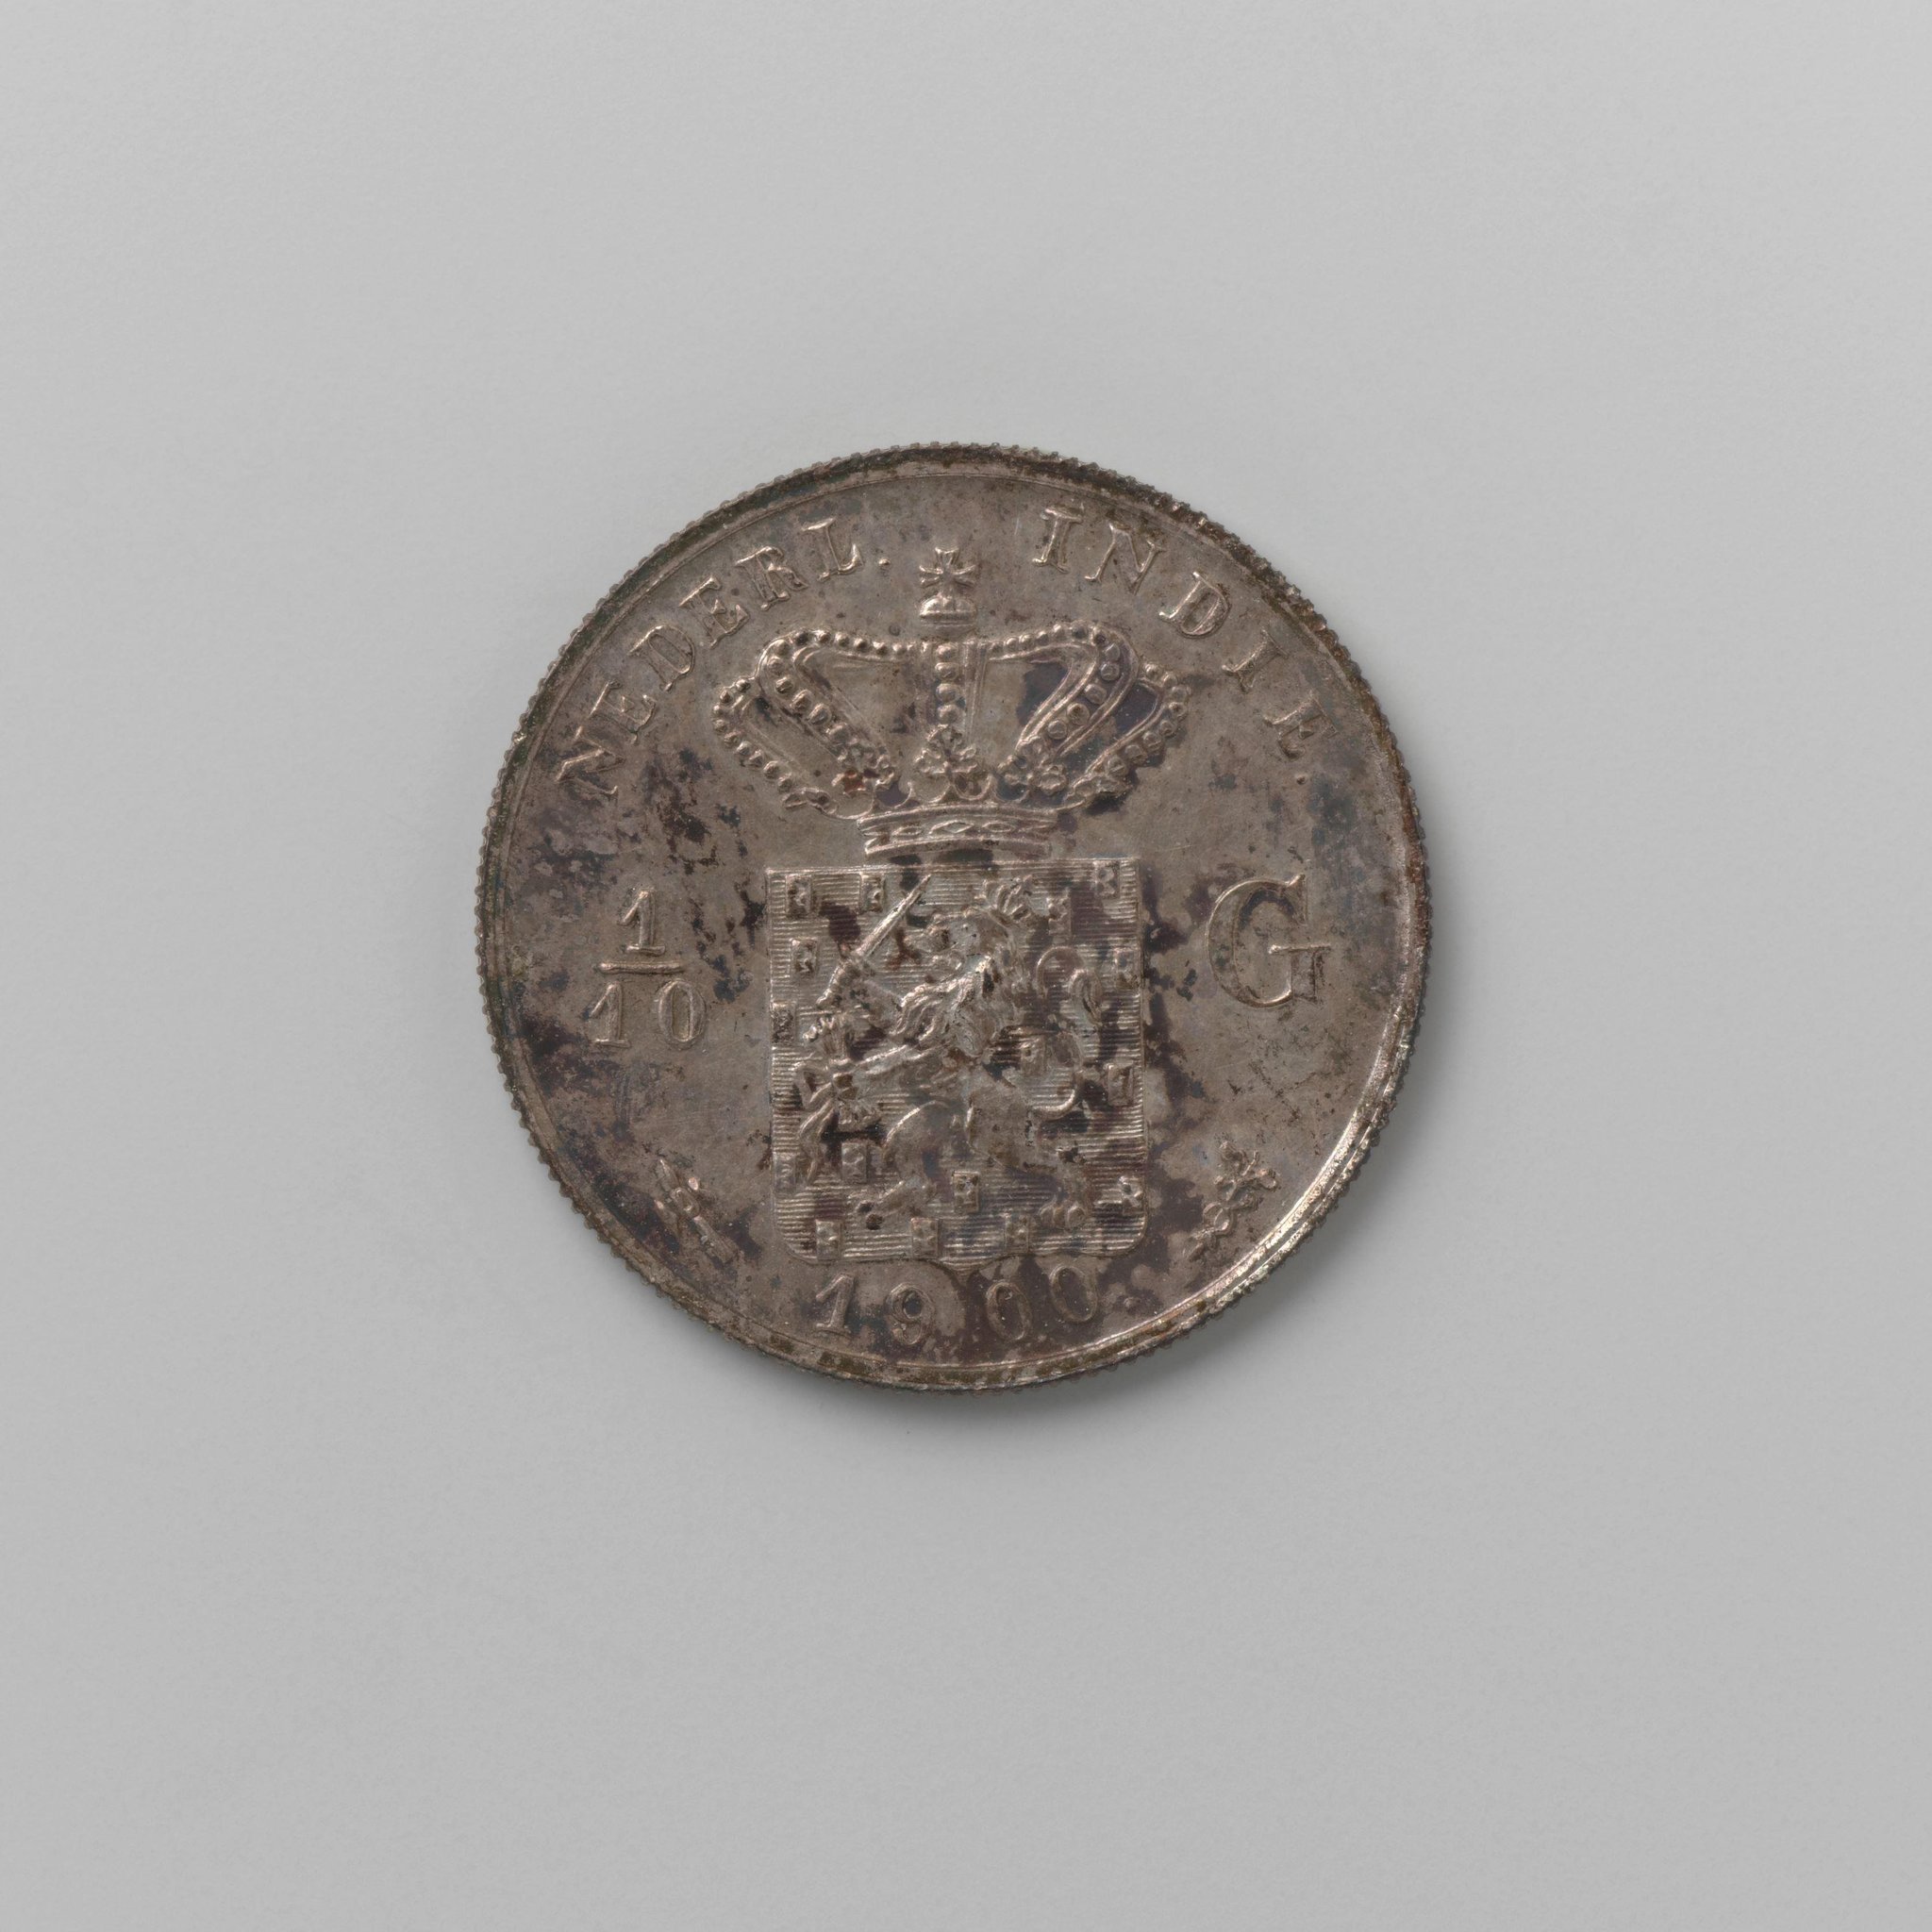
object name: coin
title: 1/10 gulden van Nederlands Indië,1900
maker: wilhelmina of the netherlands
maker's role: print maker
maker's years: 1880-1962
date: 1900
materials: copper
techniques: striking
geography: utrecht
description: Zilveren munt. Voorzijde: tussen waarde-aanduiding 1/10 G gekroond rijkswapenschild. Boven kroon landsaanduiding en onder wapenschild jaartal. Keerzijde: tweeregelig Maleis opschrift in Arabische tekens, waaromheen omschrift in het Javaans. Kartelrand.